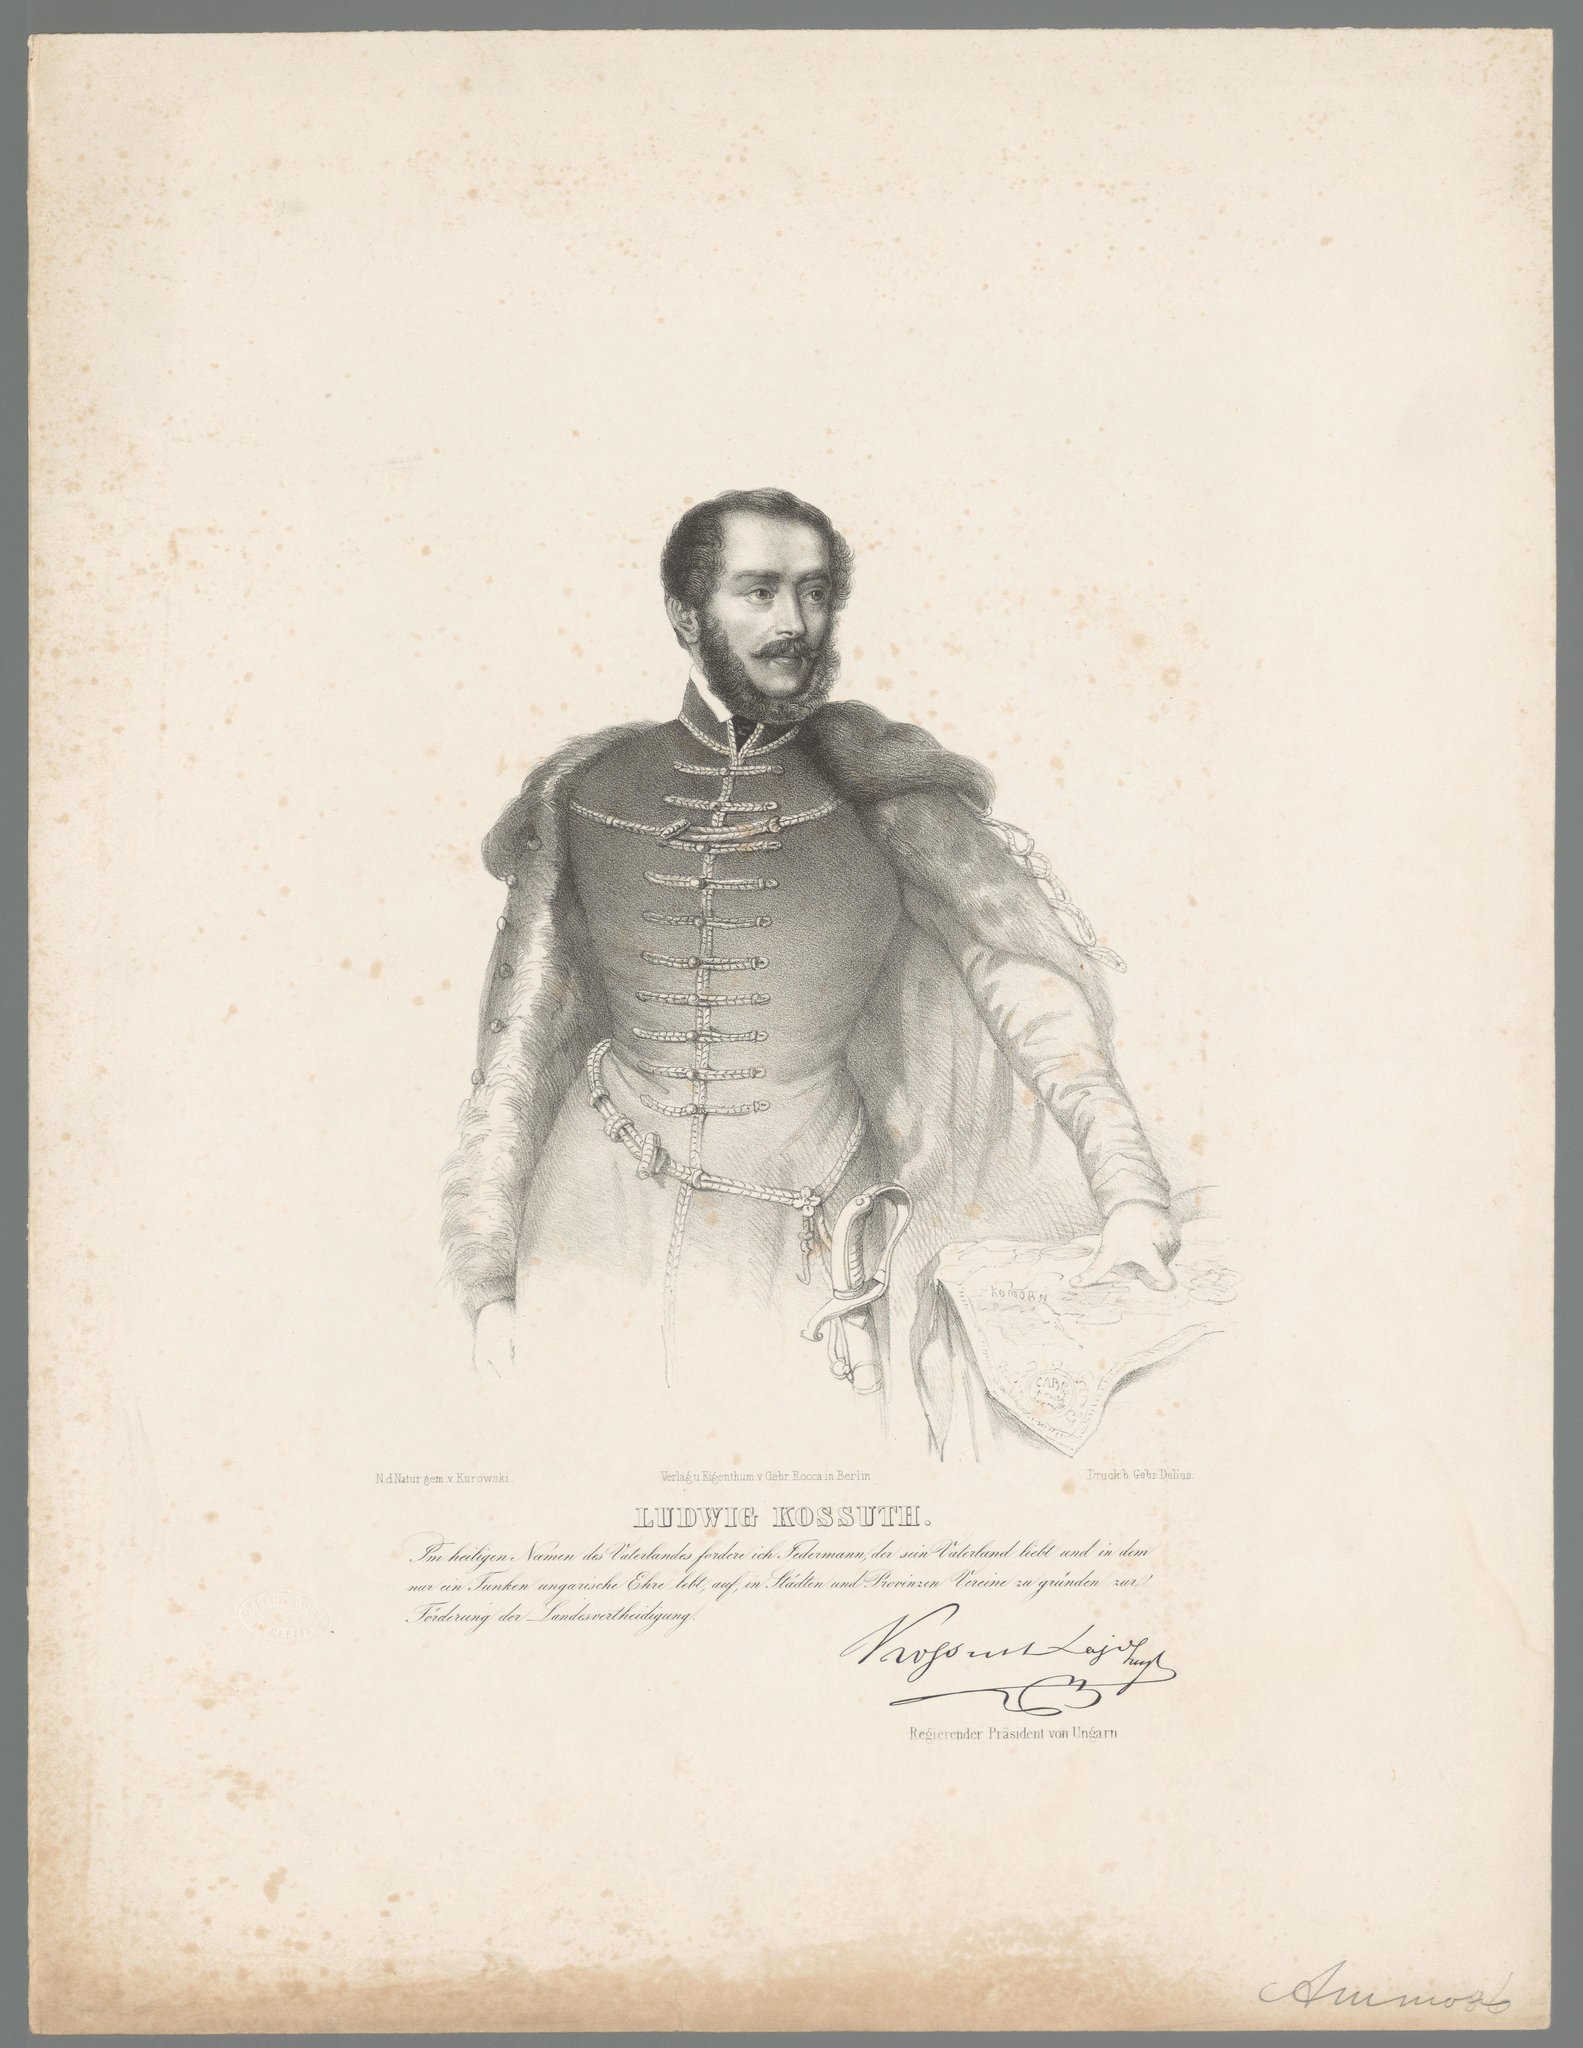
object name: print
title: Ludwig Kossuth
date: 1830-1863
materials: paper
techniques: lithograph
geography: berlin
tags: politician, maps, atlases, adult man, historical persons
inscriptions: check stamp: Lugt 2141c, collector's mark: Lugt 2228